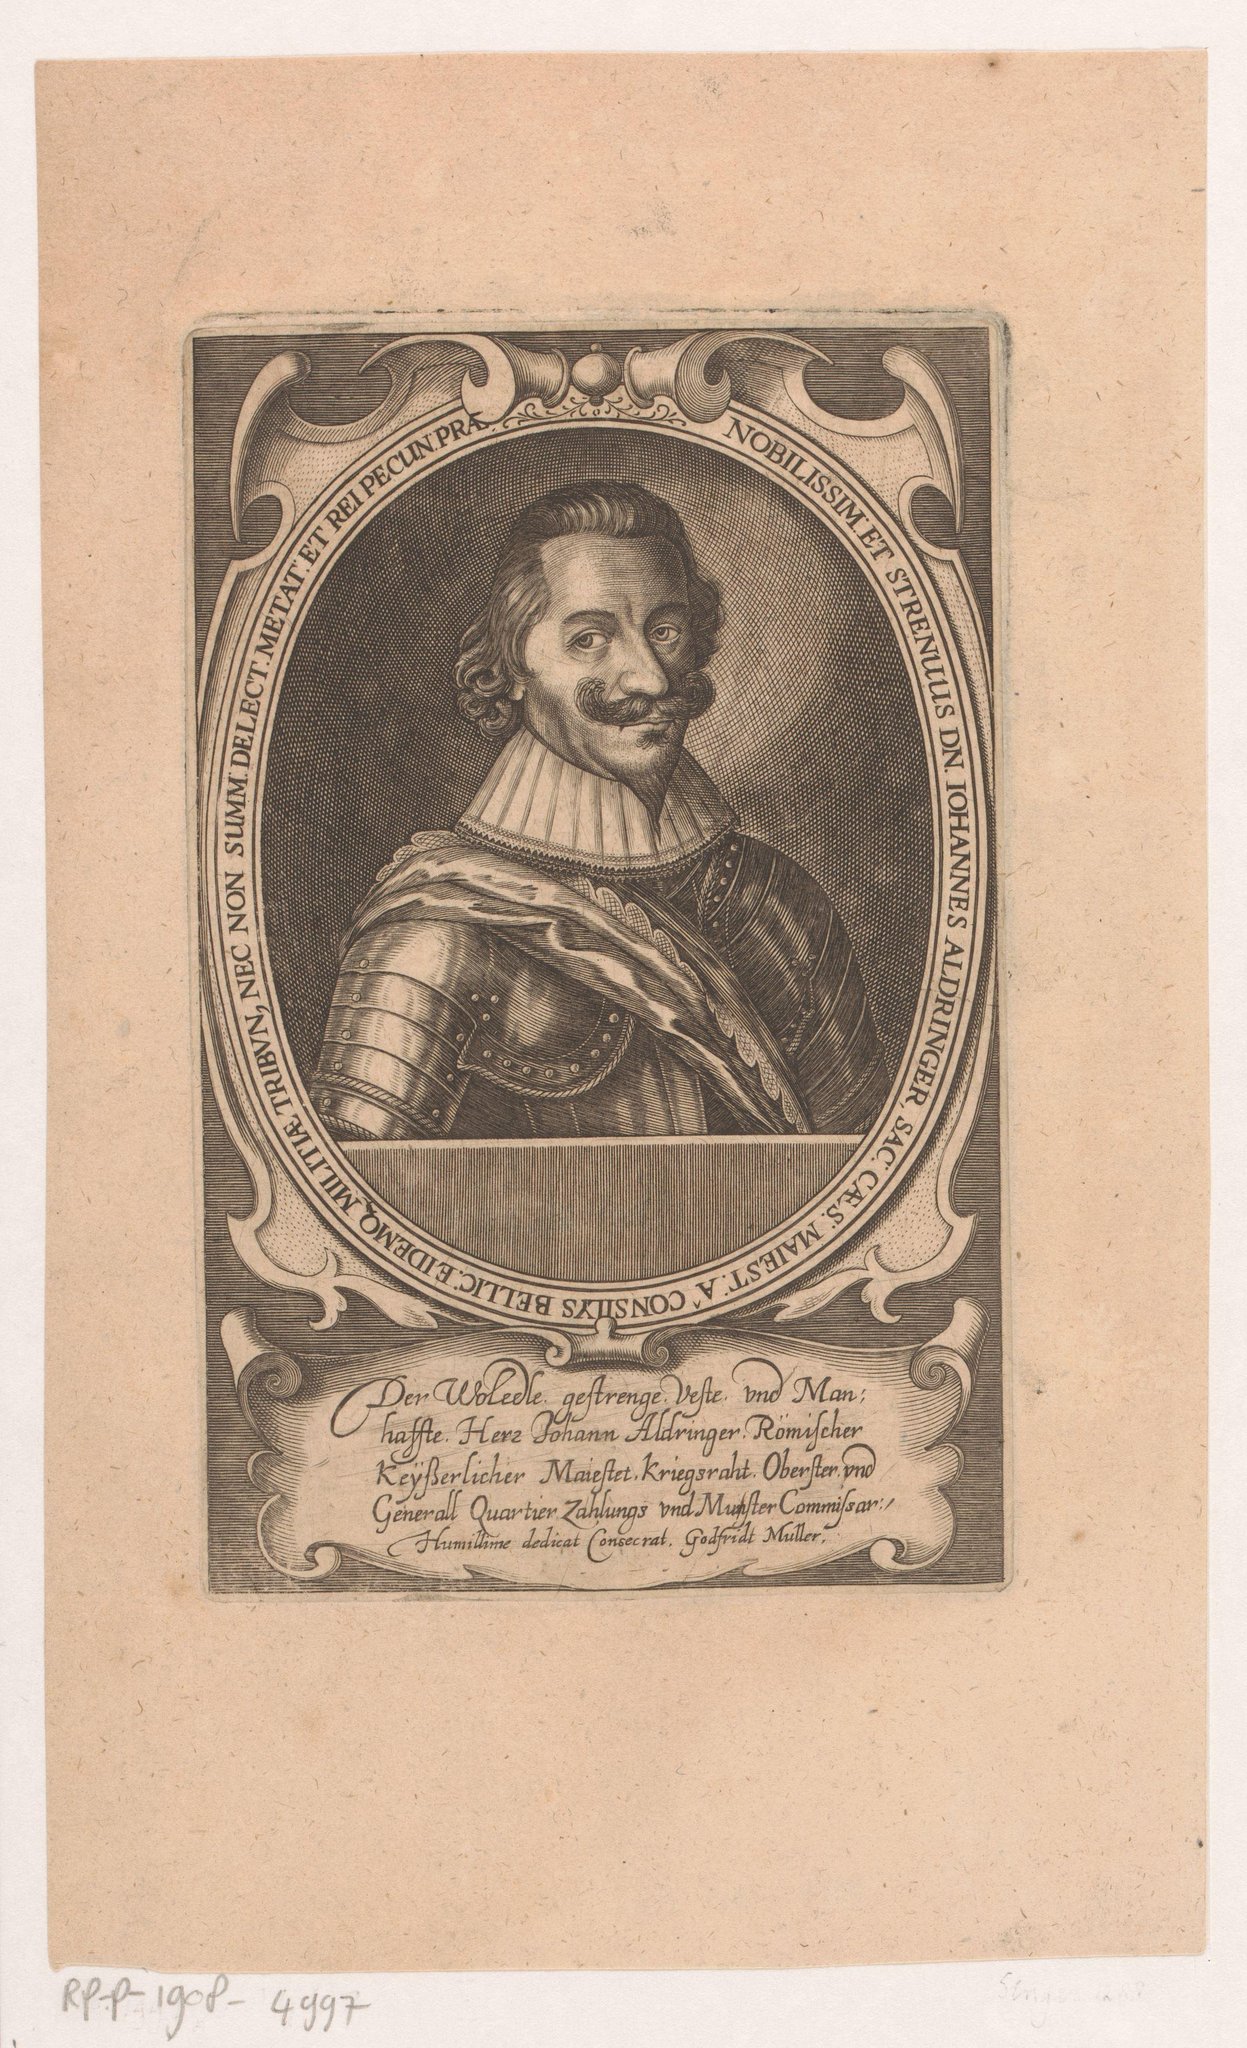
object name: print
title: Portret van Johann, graaf van Aldringen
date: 1620-1656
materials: paper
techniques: engraving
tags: armour, historical persons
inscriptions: collector's mark: Lugt 2228